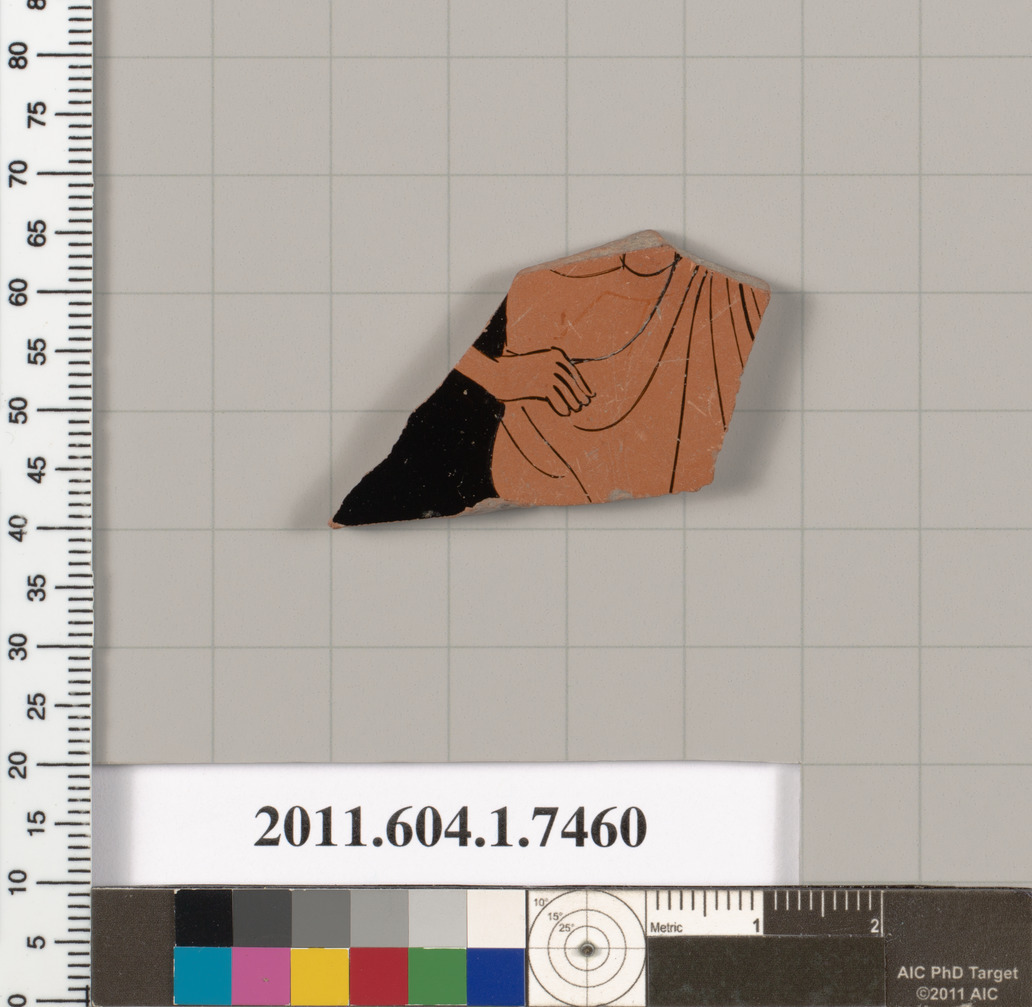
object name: kylix fragment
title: Terracotta fragment of a kylix (drinking cup)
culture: greek, attic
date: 470-460 BCE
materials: terracotta